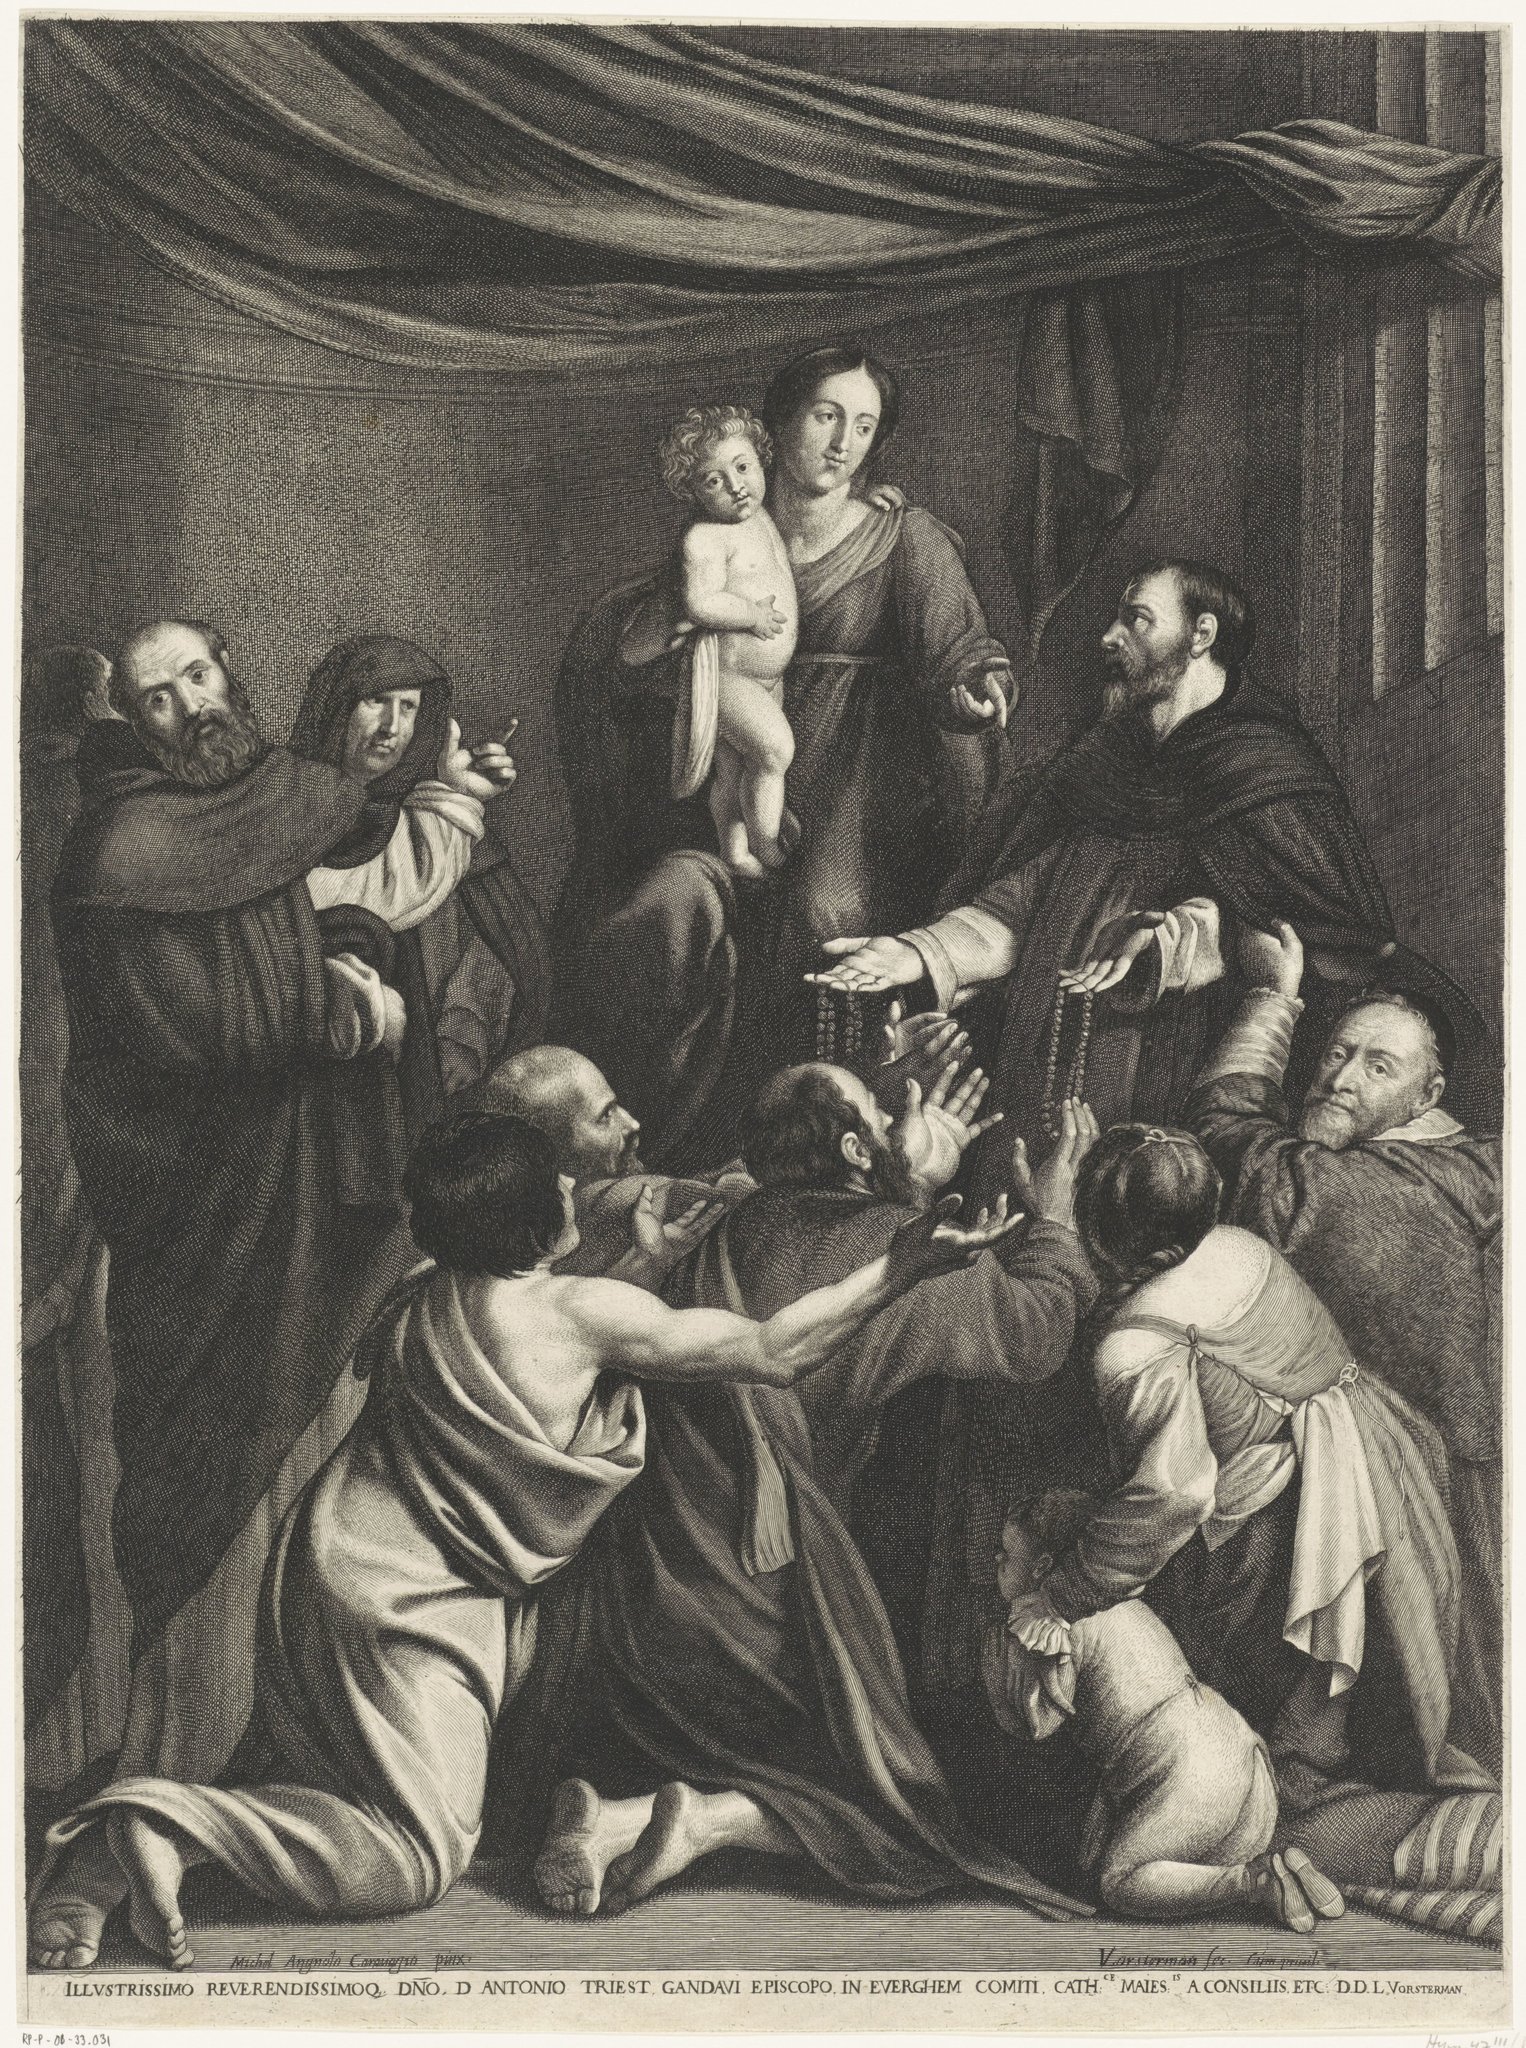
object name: print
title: Madonna van de Rozenkrans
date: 1619-1675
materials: paper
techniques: engraving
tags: madonna of the rosary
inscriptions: collector's mark: Lugt 240